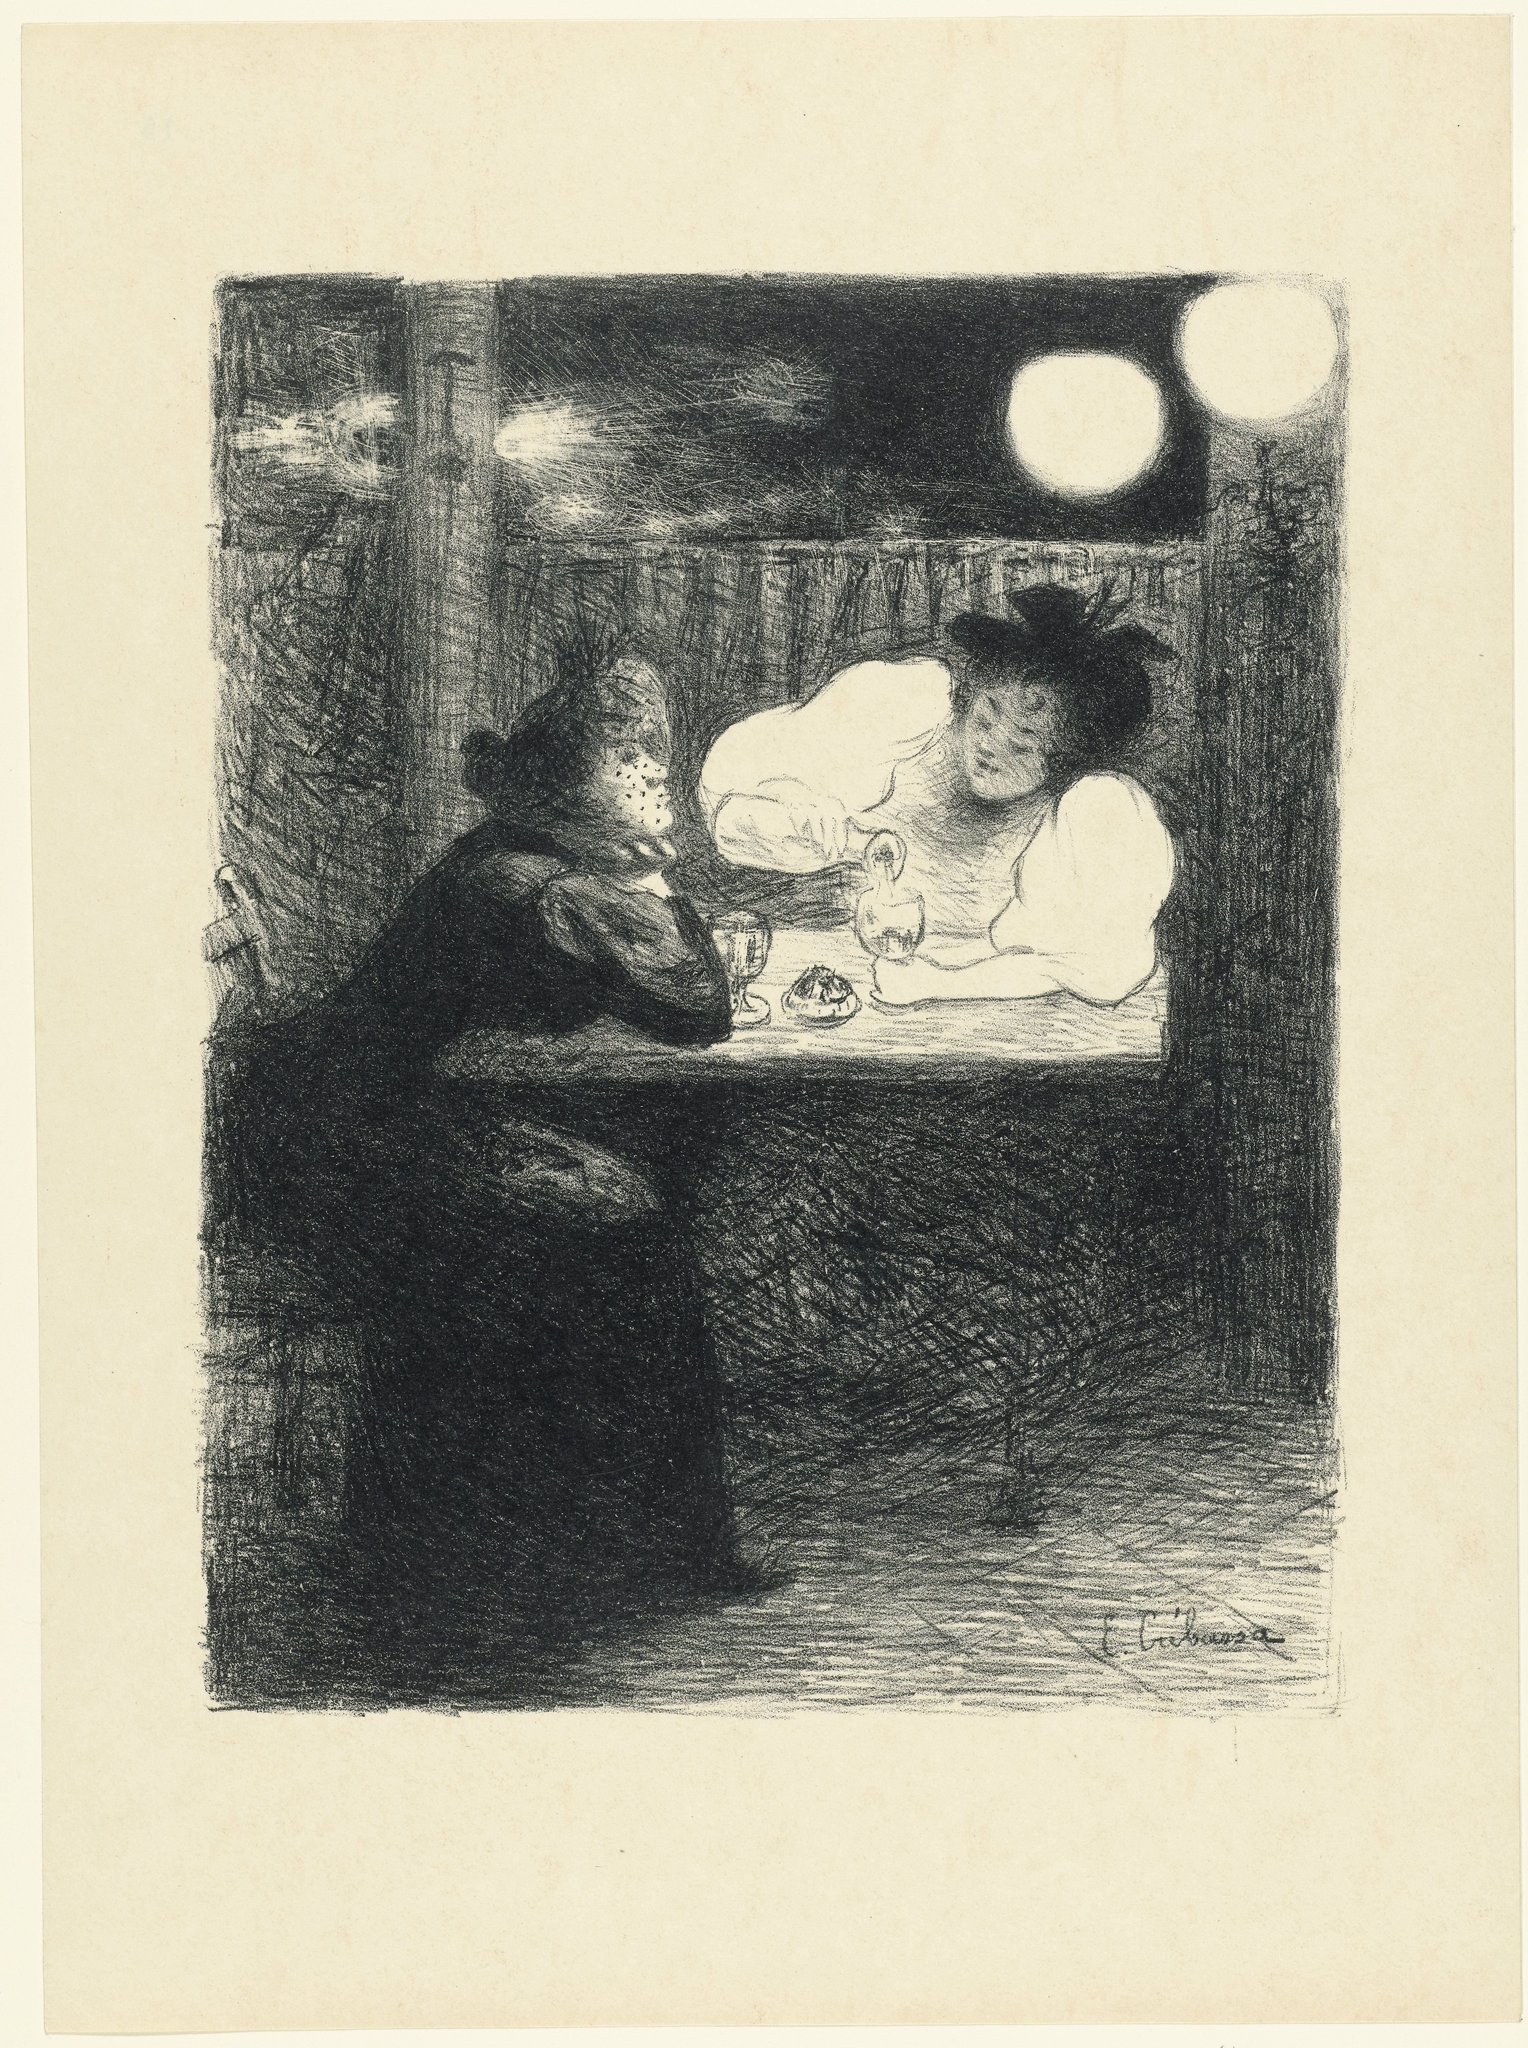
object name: print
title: Les Femmes à l'absinthe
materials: paper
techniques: lithograph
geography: paris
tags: female sex; woman, inn, coffee-house, public house, etc., drinking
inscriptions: collector's mark: Lugt 2228, collector's mark: Lugt 2760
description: Twee vrouwen zitten aan een tafel in een café. De vrouw links leunt op de tafel met haar ellebogen en ondersteunt haar hoofd met haar handen. De andere vrouw schenkt haar glas vol uit een fles. Met haar lichte kleding steekt zij af tegen de donkere achtergrond.